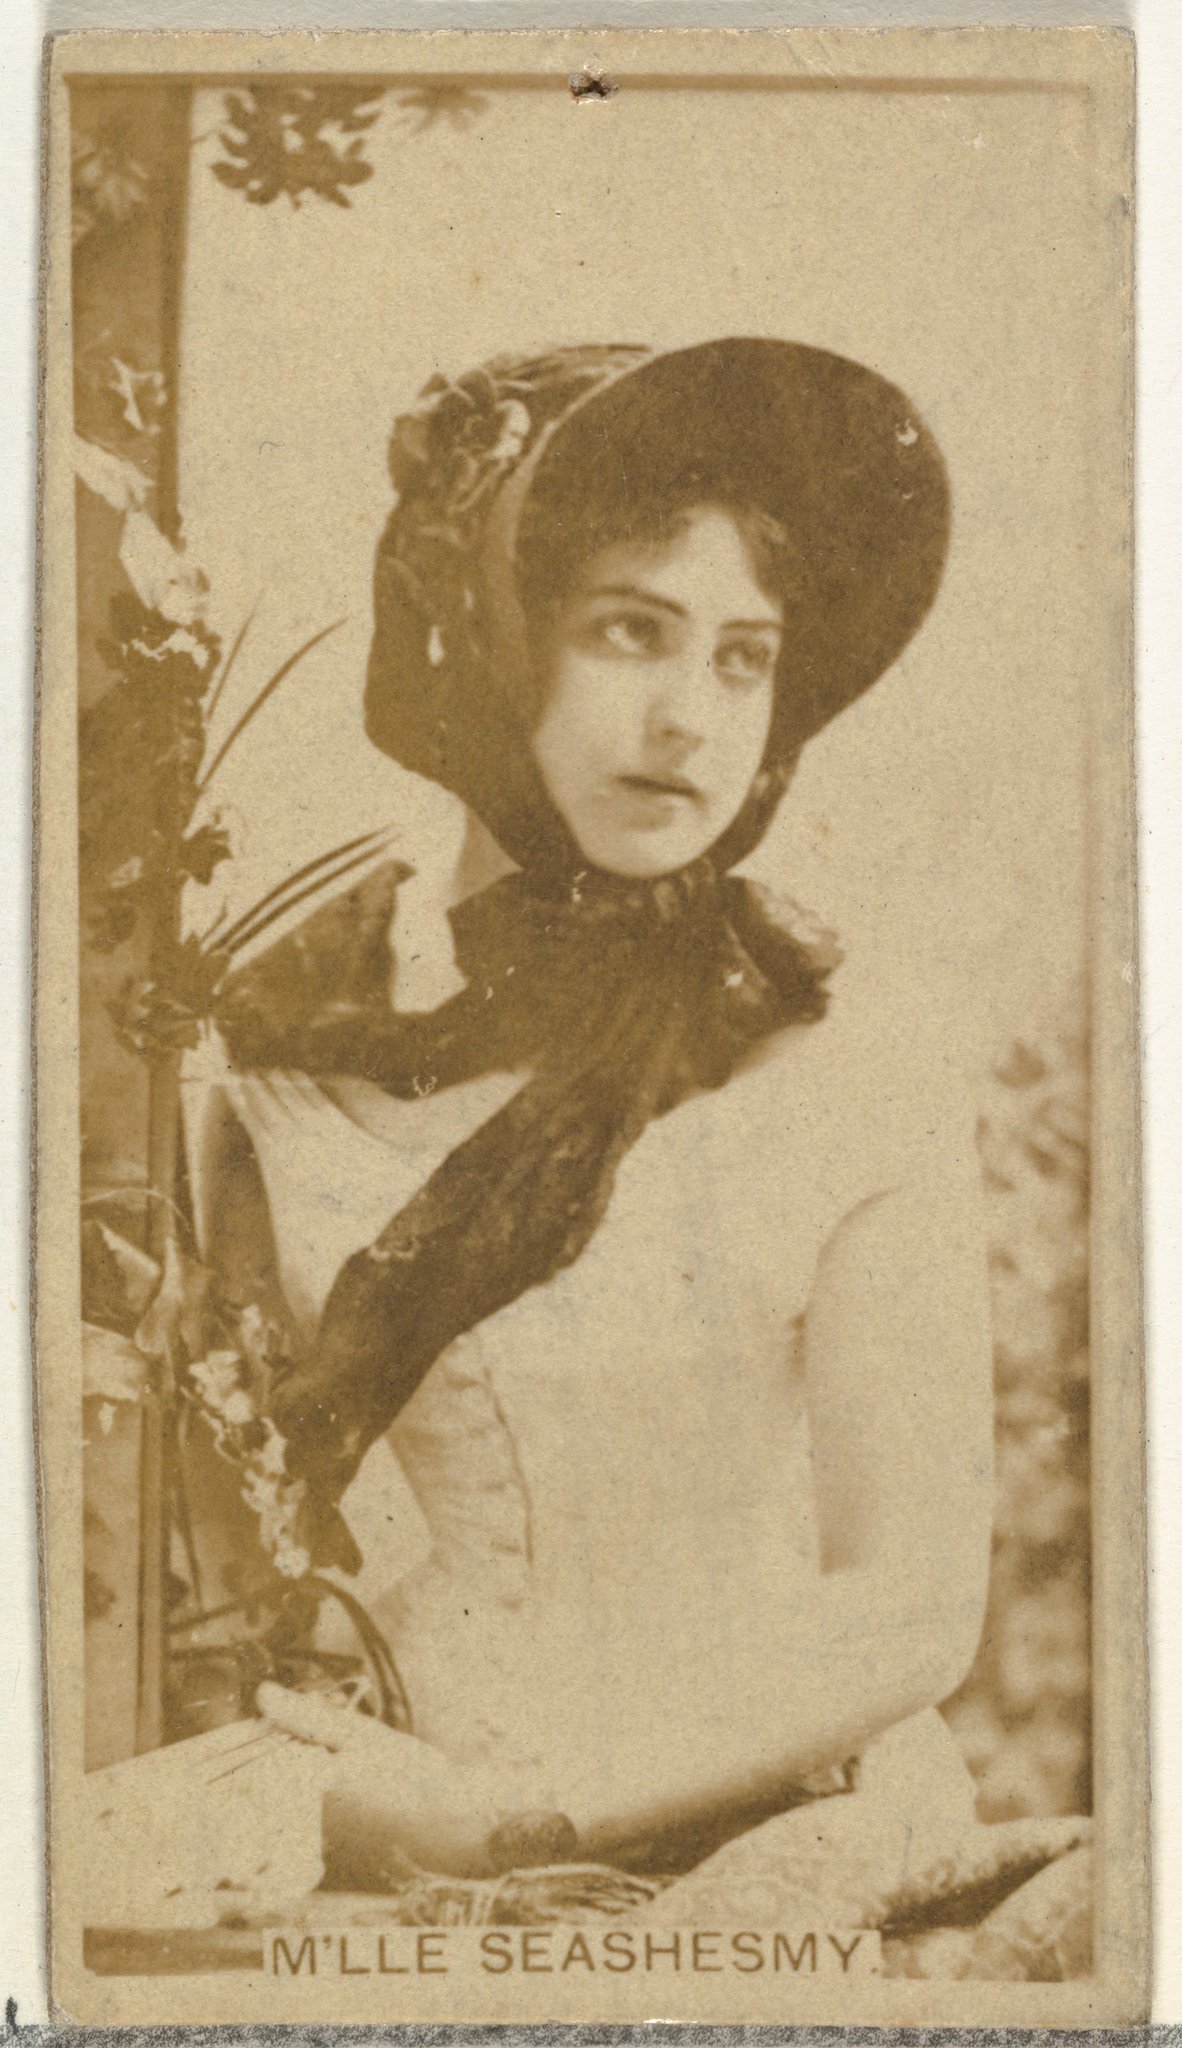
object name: photograph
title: M'lle Seashesmy, from the Actors and Actresses series (N145-8) issued by Duke Sons & Co. to promote Duke Cigarettes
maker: w. duke, sons & co.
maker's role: publisher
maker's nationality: american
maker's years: 1870-1920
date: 1891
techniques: albumen silver print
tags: portraits,women,actresses